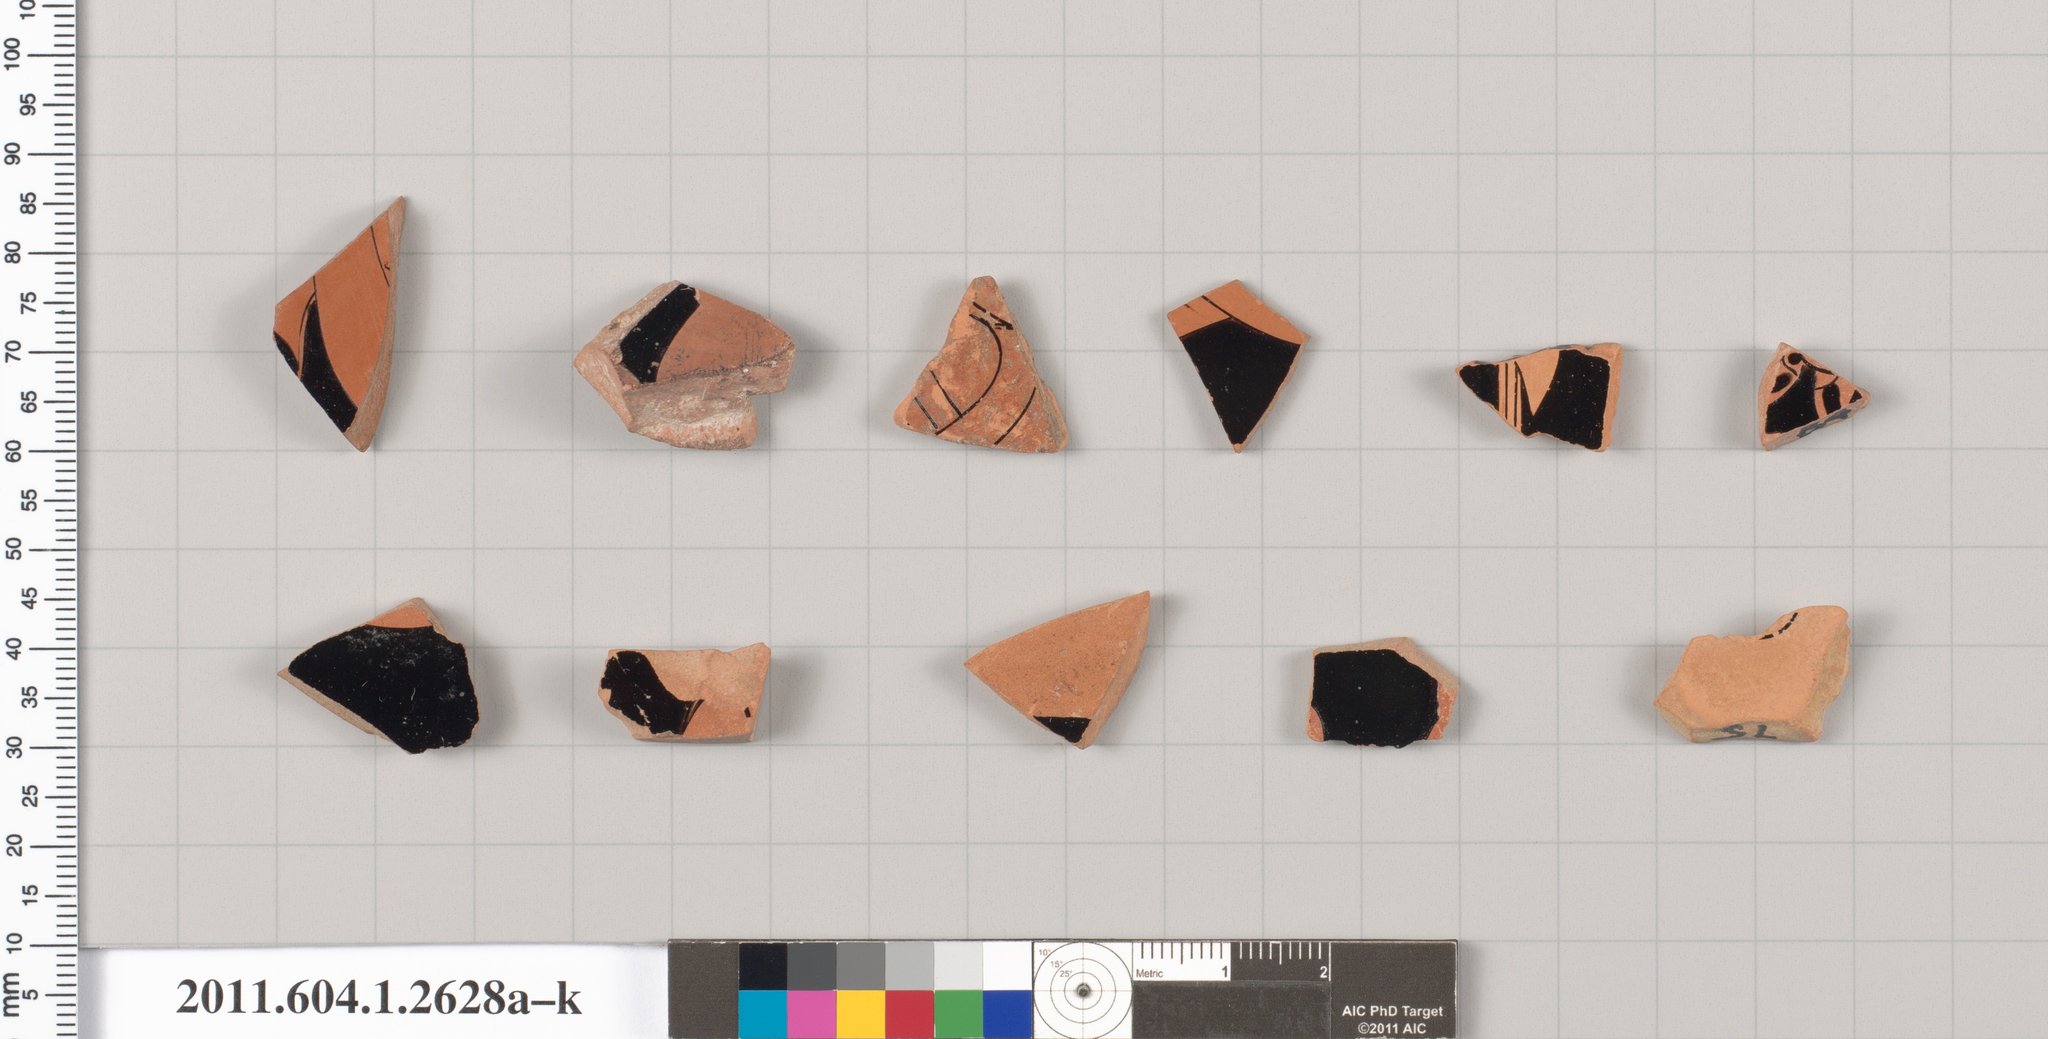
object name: kylix fragment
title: Terracotta fragments of kylikes (drinking cups)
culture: greek, attic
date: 500-401 BCE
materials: terracotta